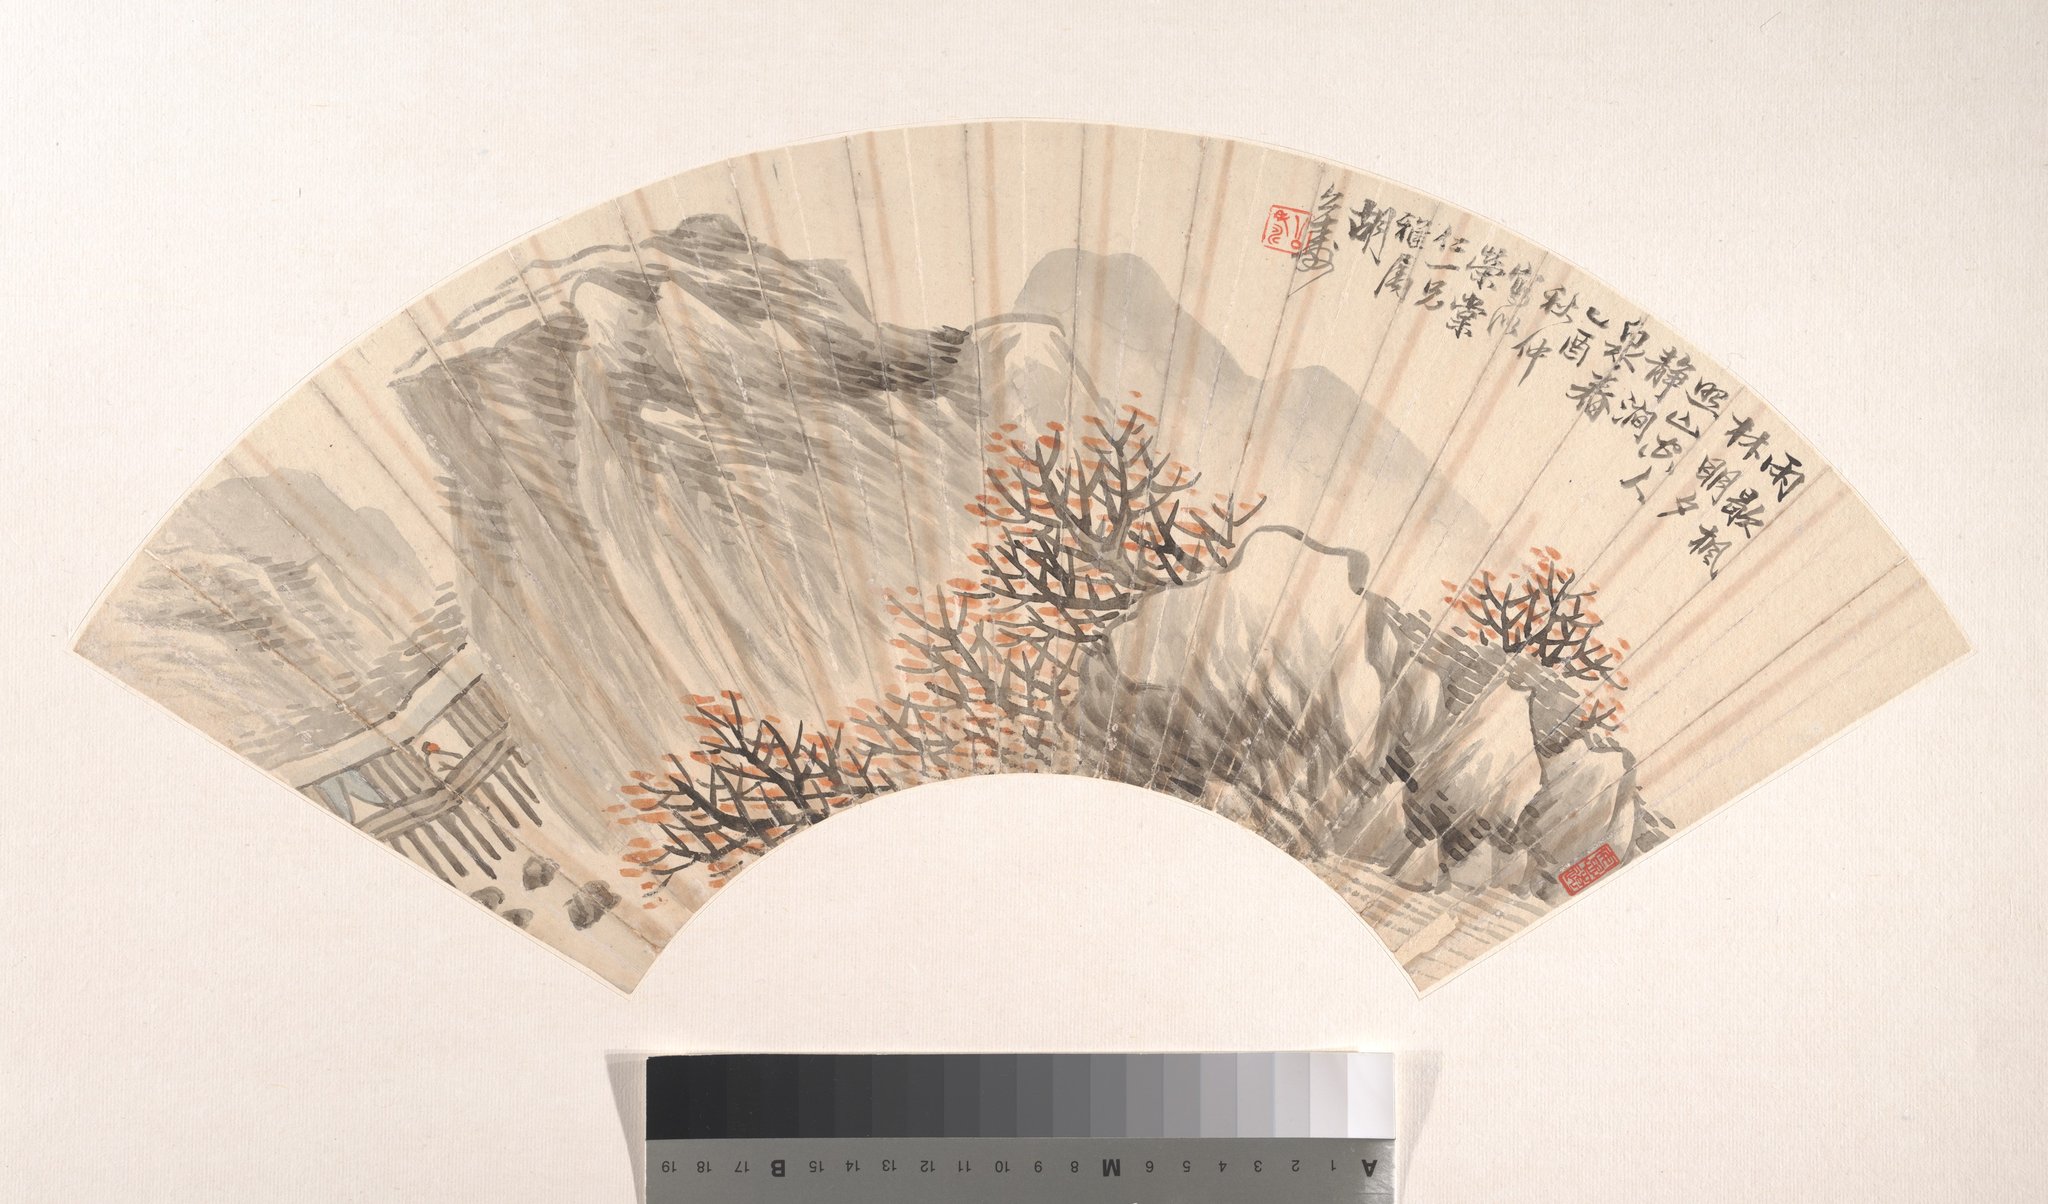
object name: folding fan mounted a an album leaf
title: Landscape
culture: chinese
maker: hu yuan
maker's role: artist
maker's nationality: chinese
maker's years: 1823-1886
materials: ink, paper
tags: mountains,landscapes